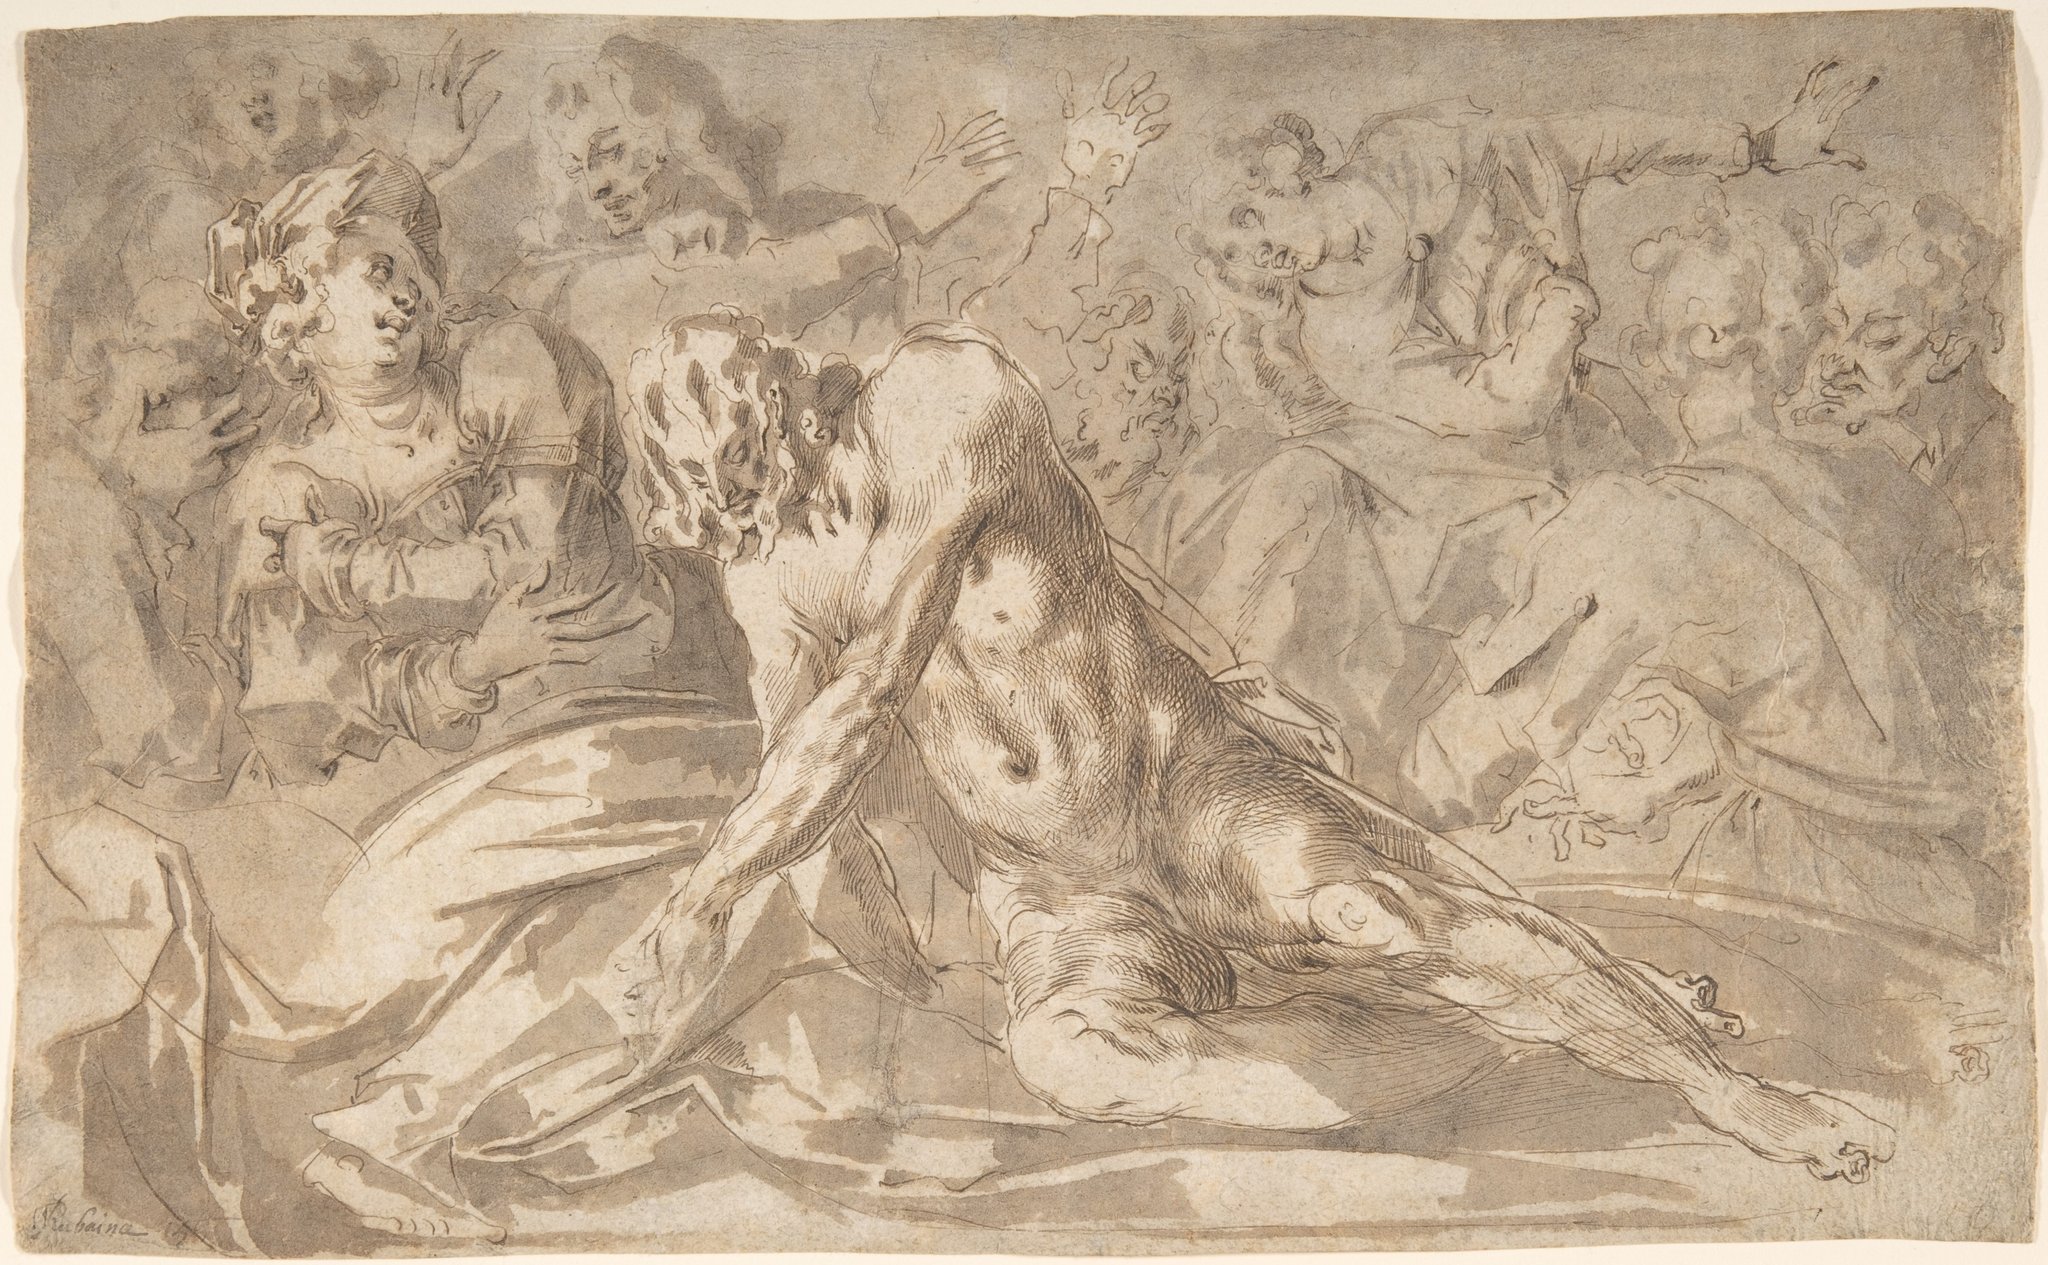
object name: drawing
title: The Raising of Lazarus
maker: jacques bellange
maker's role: artist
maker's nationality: french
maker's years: 1575-1616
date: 1606-1608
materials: ink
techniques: pen, wash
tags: male nudes,women